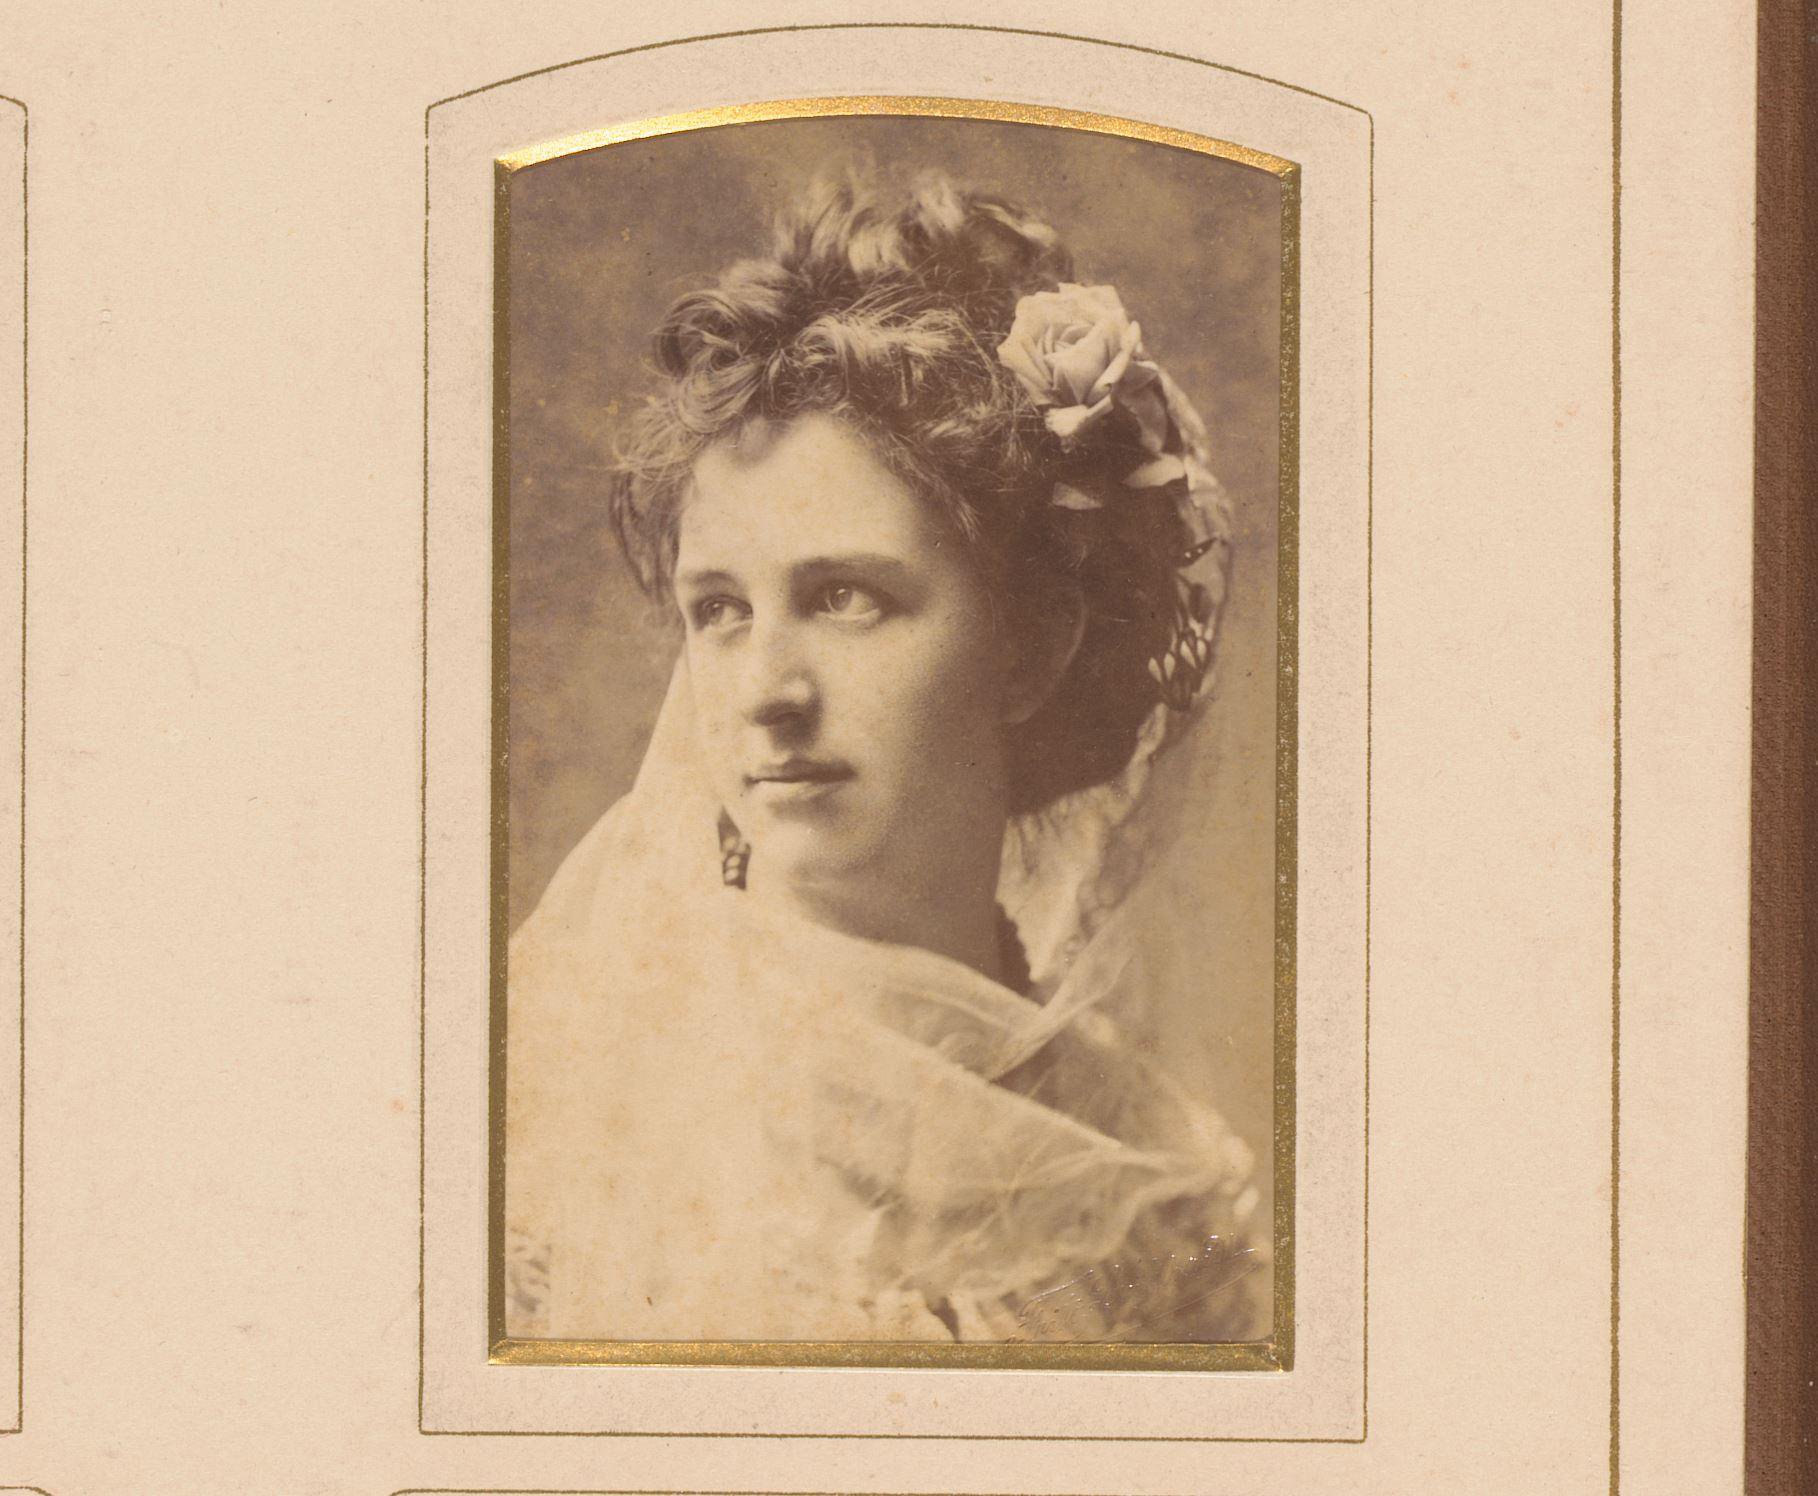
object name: carte de visite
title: Portret van een actrice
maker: fritz luckhardt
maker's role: fotograaf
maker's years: 1843-1894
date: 1865-1894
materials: cardboard, photographic support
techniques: albumen print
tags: historical persons - bb - woman, portrait of actor, actress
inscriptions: inscription: ‘Fritz Luckhardt/ k.k. Hofphotograph/ Wien/ Leopoldstr. Taborstr. 18 National Hôtel/ Vervielfältigung/ vorbehalten.’, name: ‘Fritz Luckhardt’